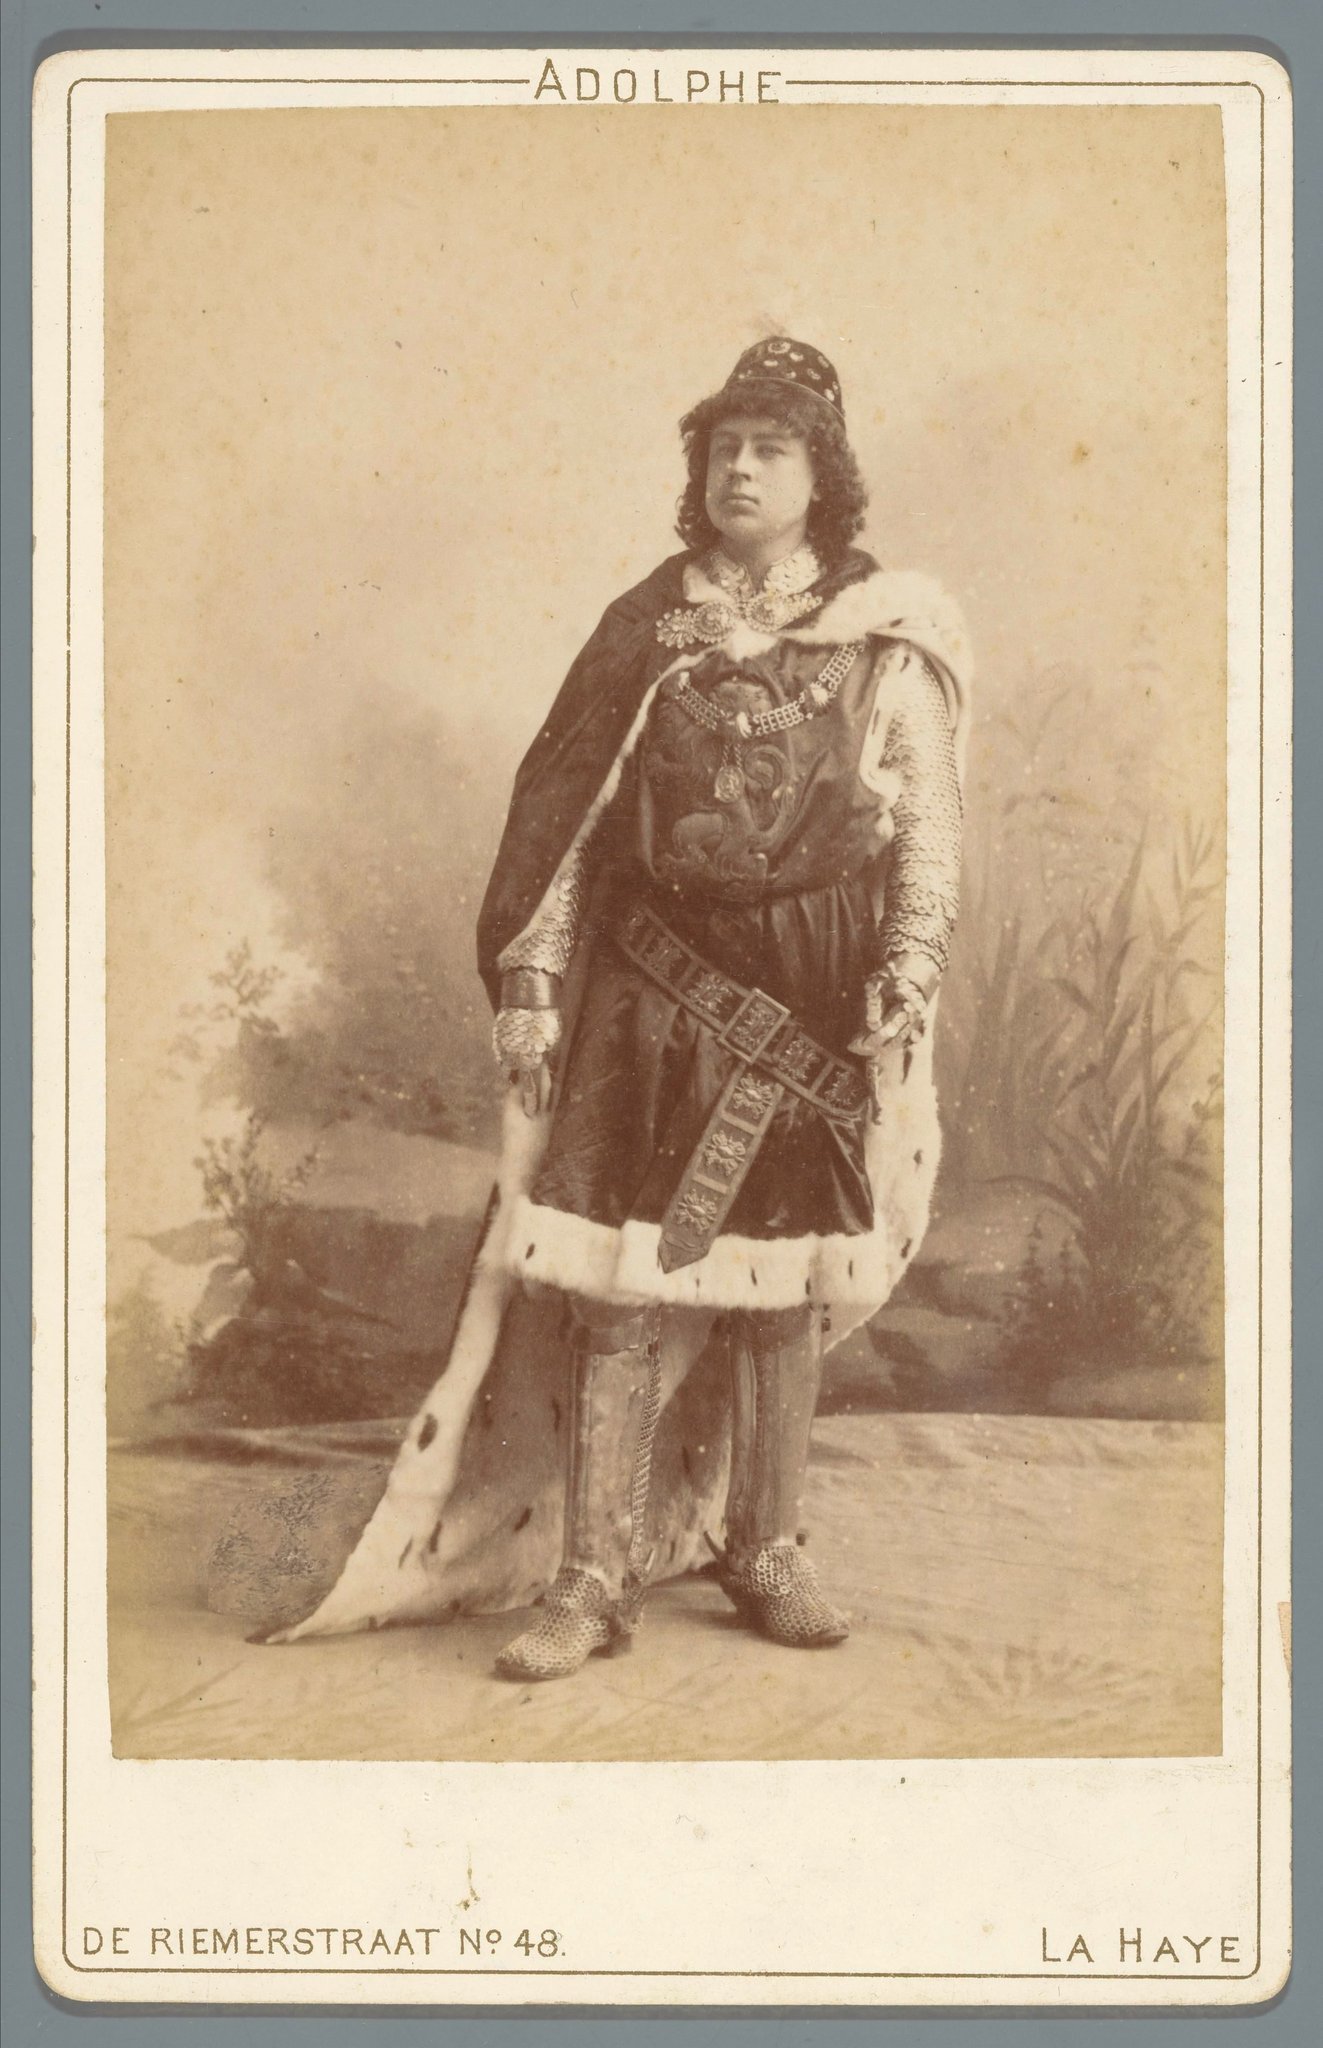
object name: cabinet photograph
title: Portret van (vermoedelijk) een acteur in kostuum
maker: adolphe zimmermans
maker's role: fotograaf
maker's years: 1858-1922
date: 1885-1900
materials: cardboard, photographic support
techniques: albumen print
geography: the hague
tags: portrait of actor, actress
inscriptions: inscription: ‘Adolphe Zimmermans (...) Médaille d'Anvers 1885.’, inscription: ‘Marie’